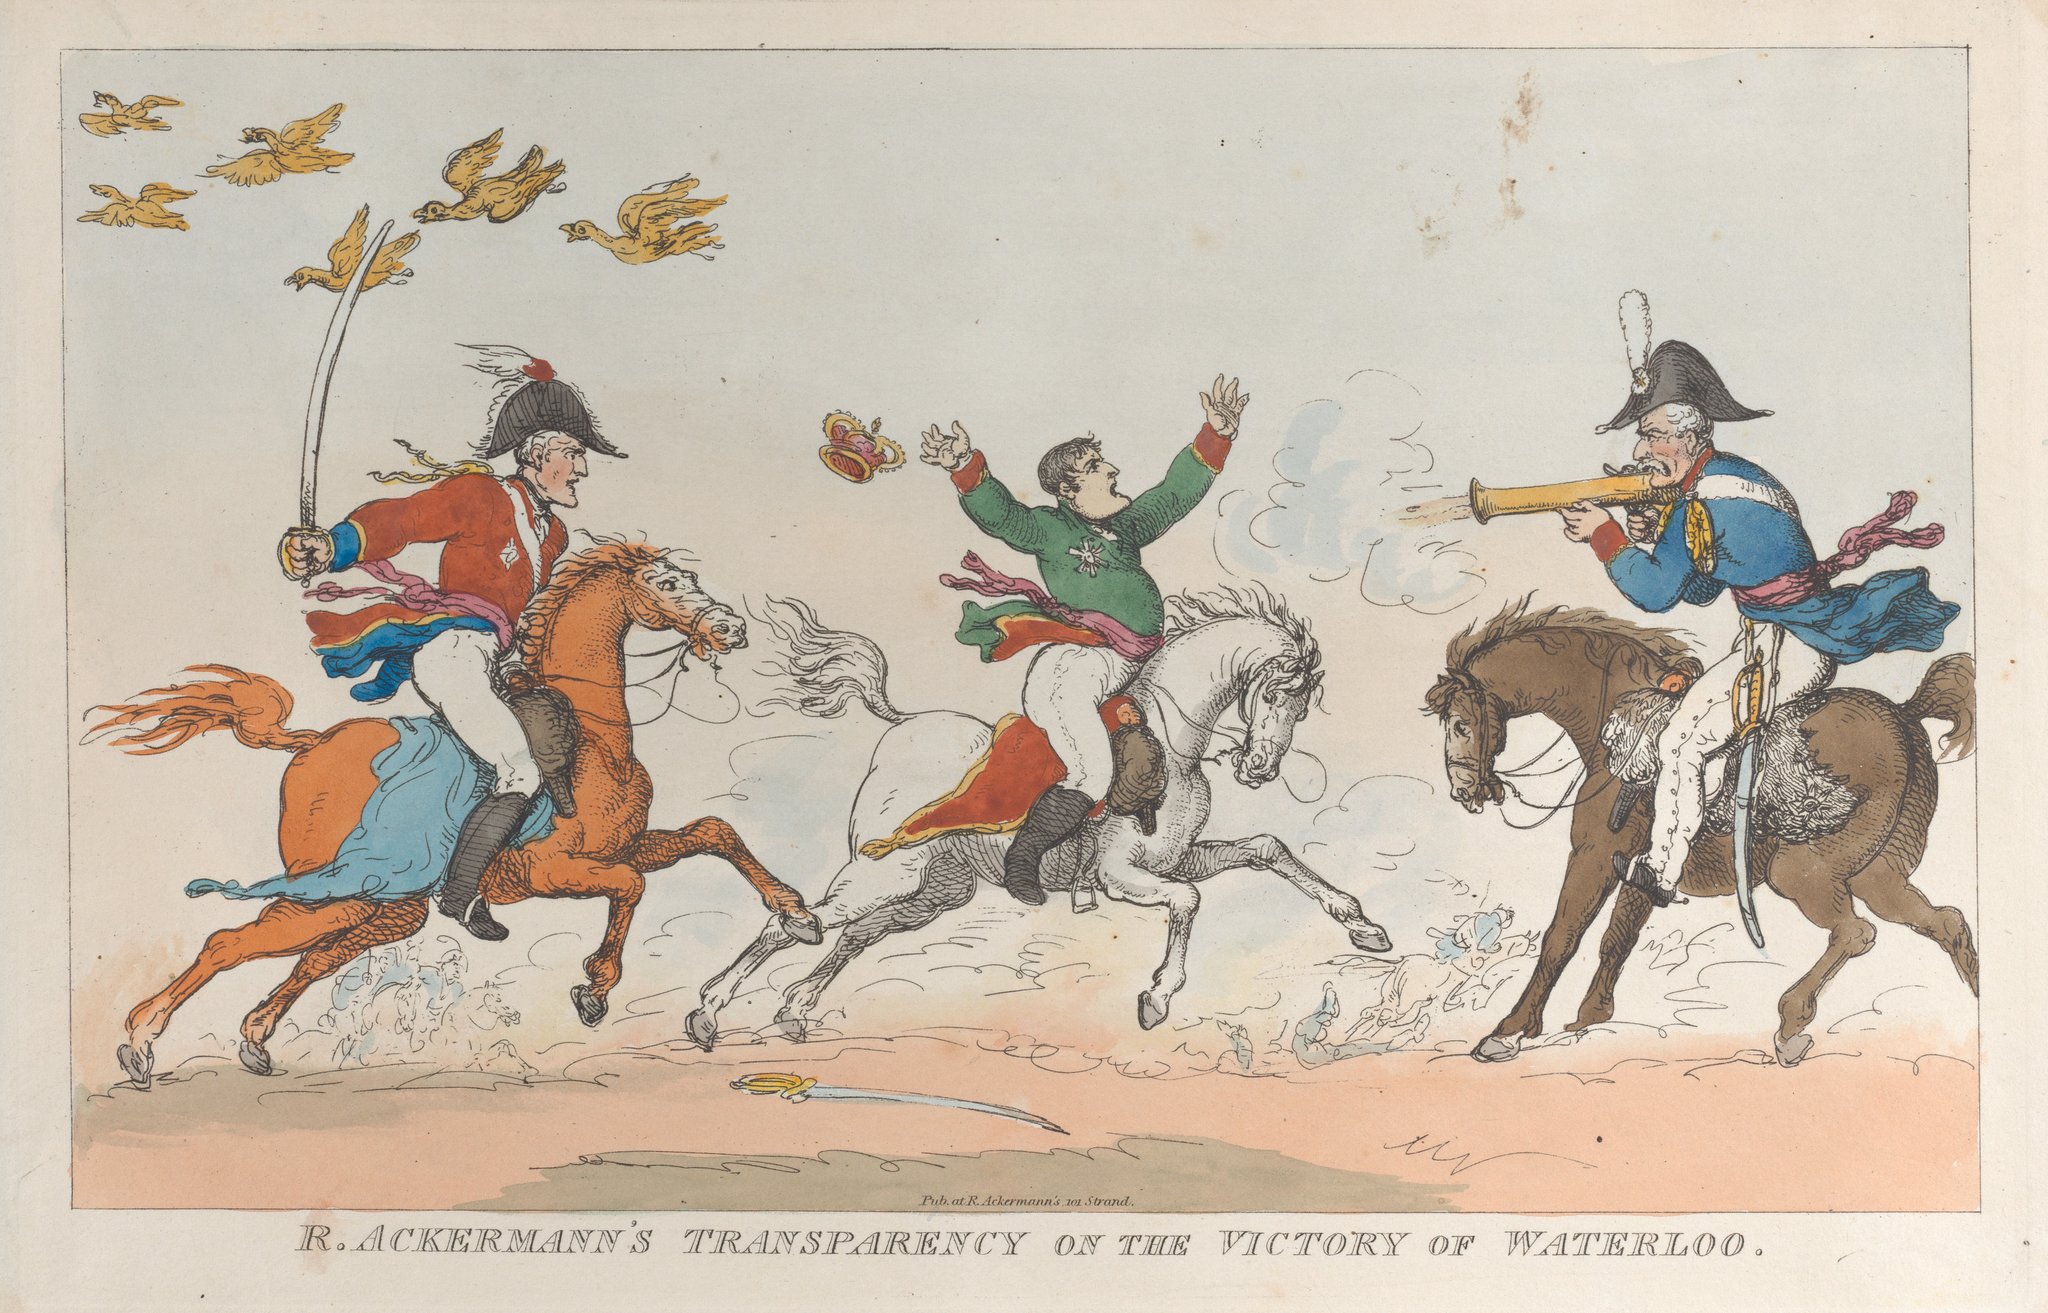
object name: print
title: R. Ackermann's Transparency on the Victory of Waterloo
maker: thomas rowlandson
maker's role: artist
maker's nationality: british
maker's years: 1757-1827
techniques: etching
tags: satire,napoleon i,men,horses,politics